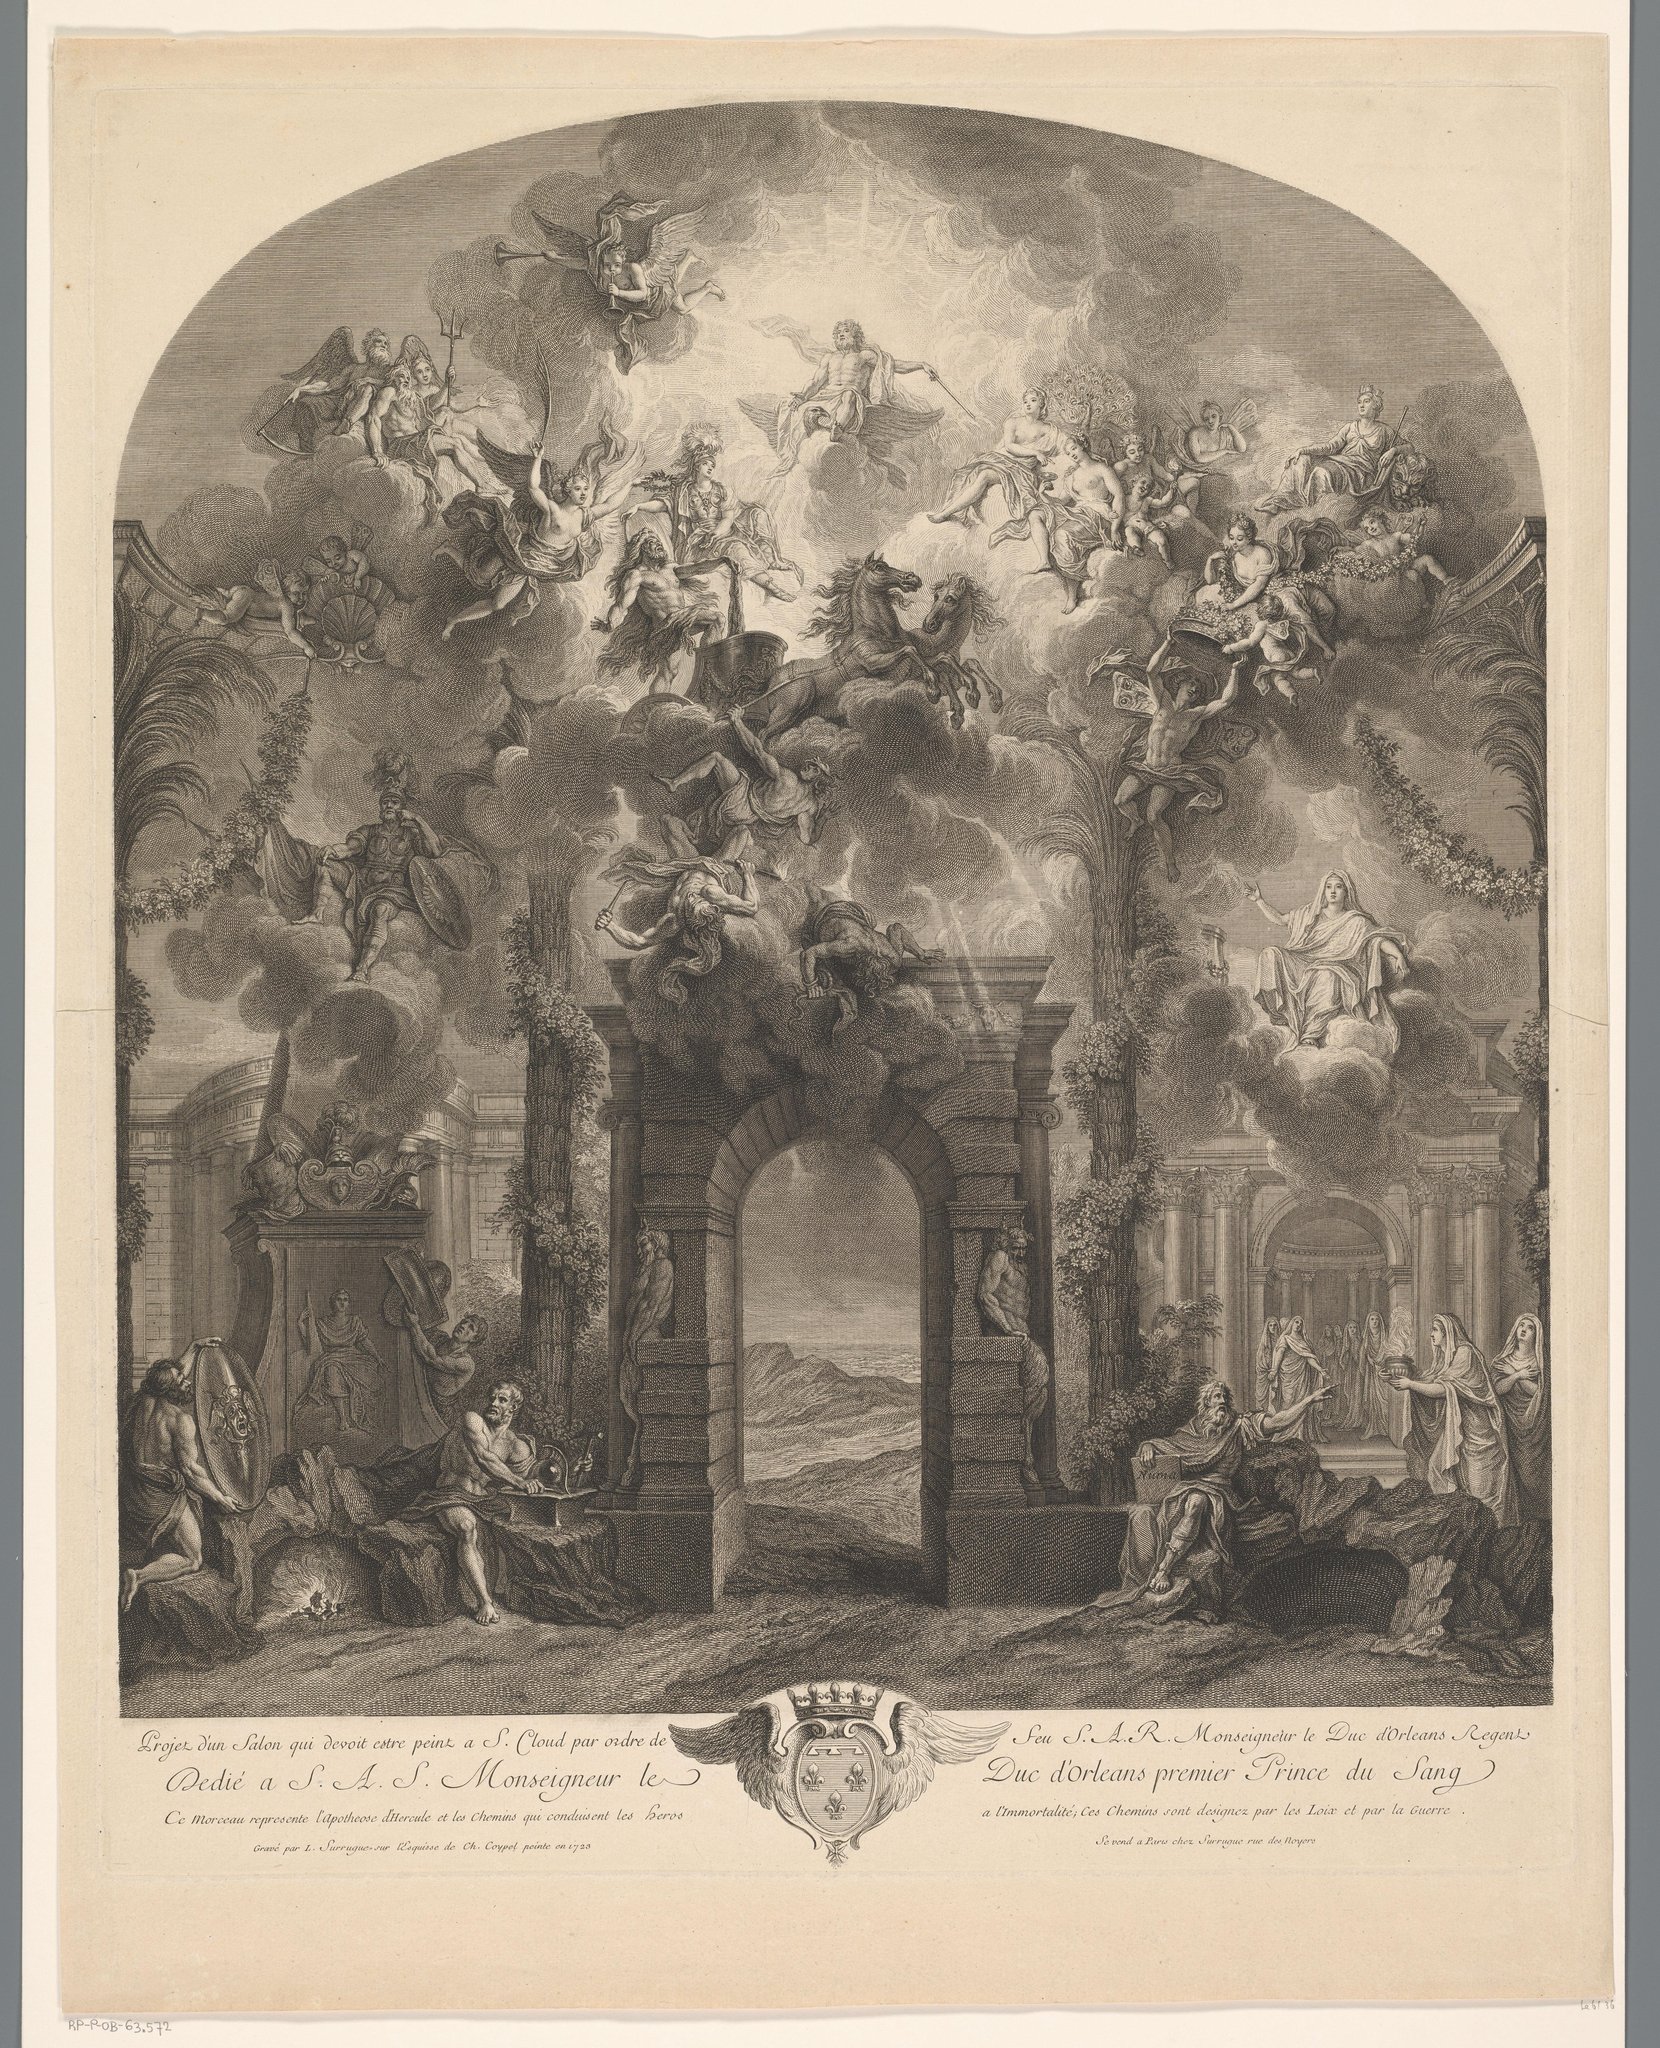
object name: print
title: Projet d'un Salon qui devoit estre peint a S. Cloud (...)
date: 1723-1752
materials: paper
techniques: engraving, etching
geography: paris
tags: apotheosis of hercules: he is borne to heaven in a four-horse chariot and reconciled with juno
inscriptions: collector's mark: Lugt 2228